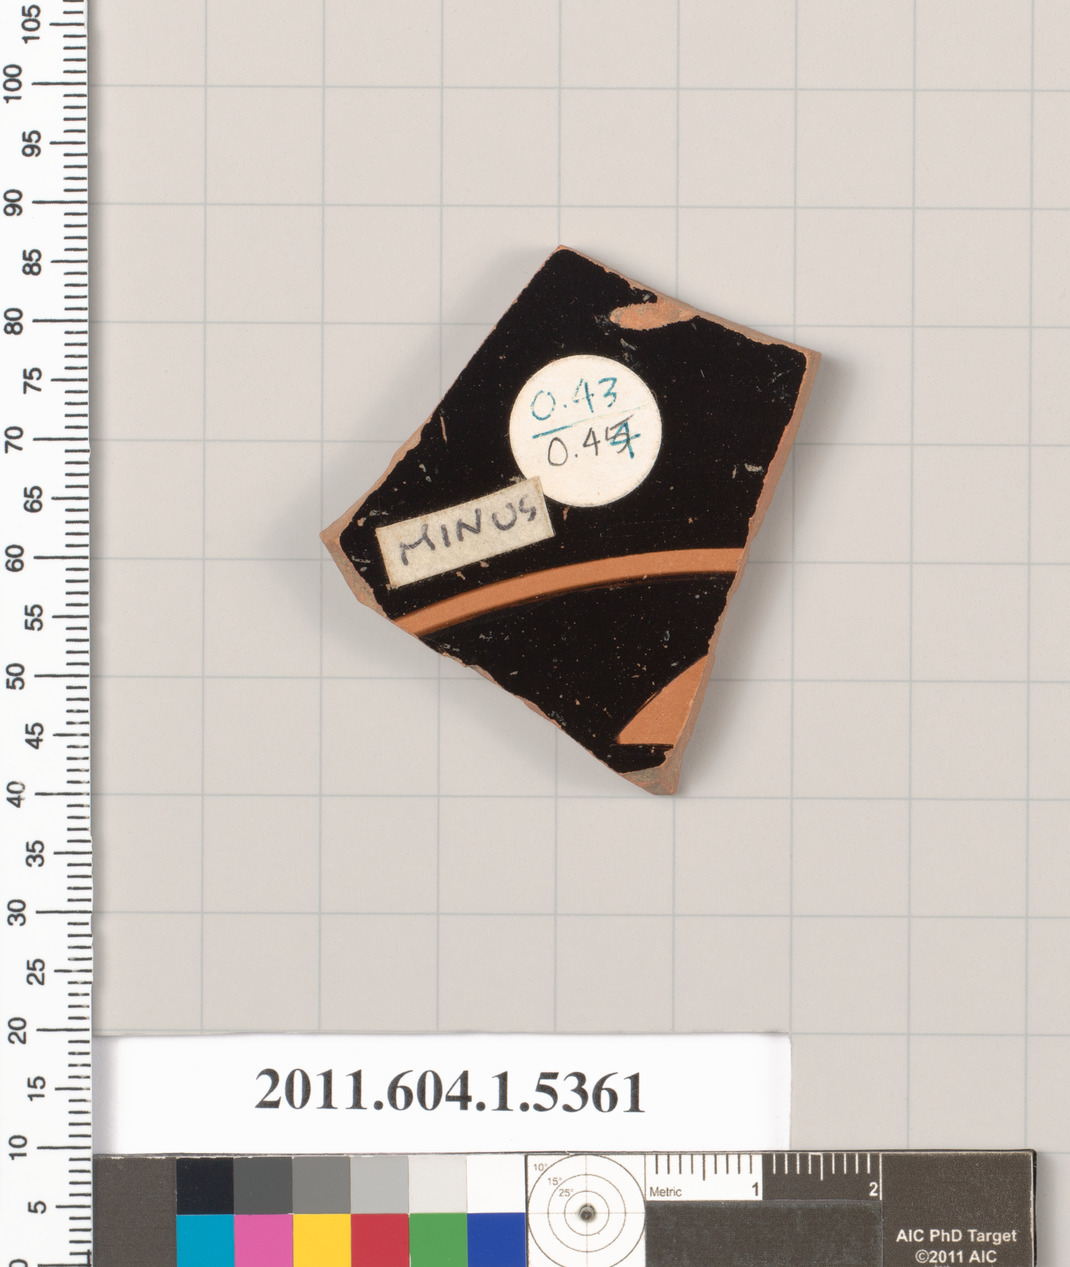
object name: kylix fragment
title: Terracotta fragment of a kylix (drinking cup)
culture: greek, attic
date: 520-500 BCE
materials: terracotta